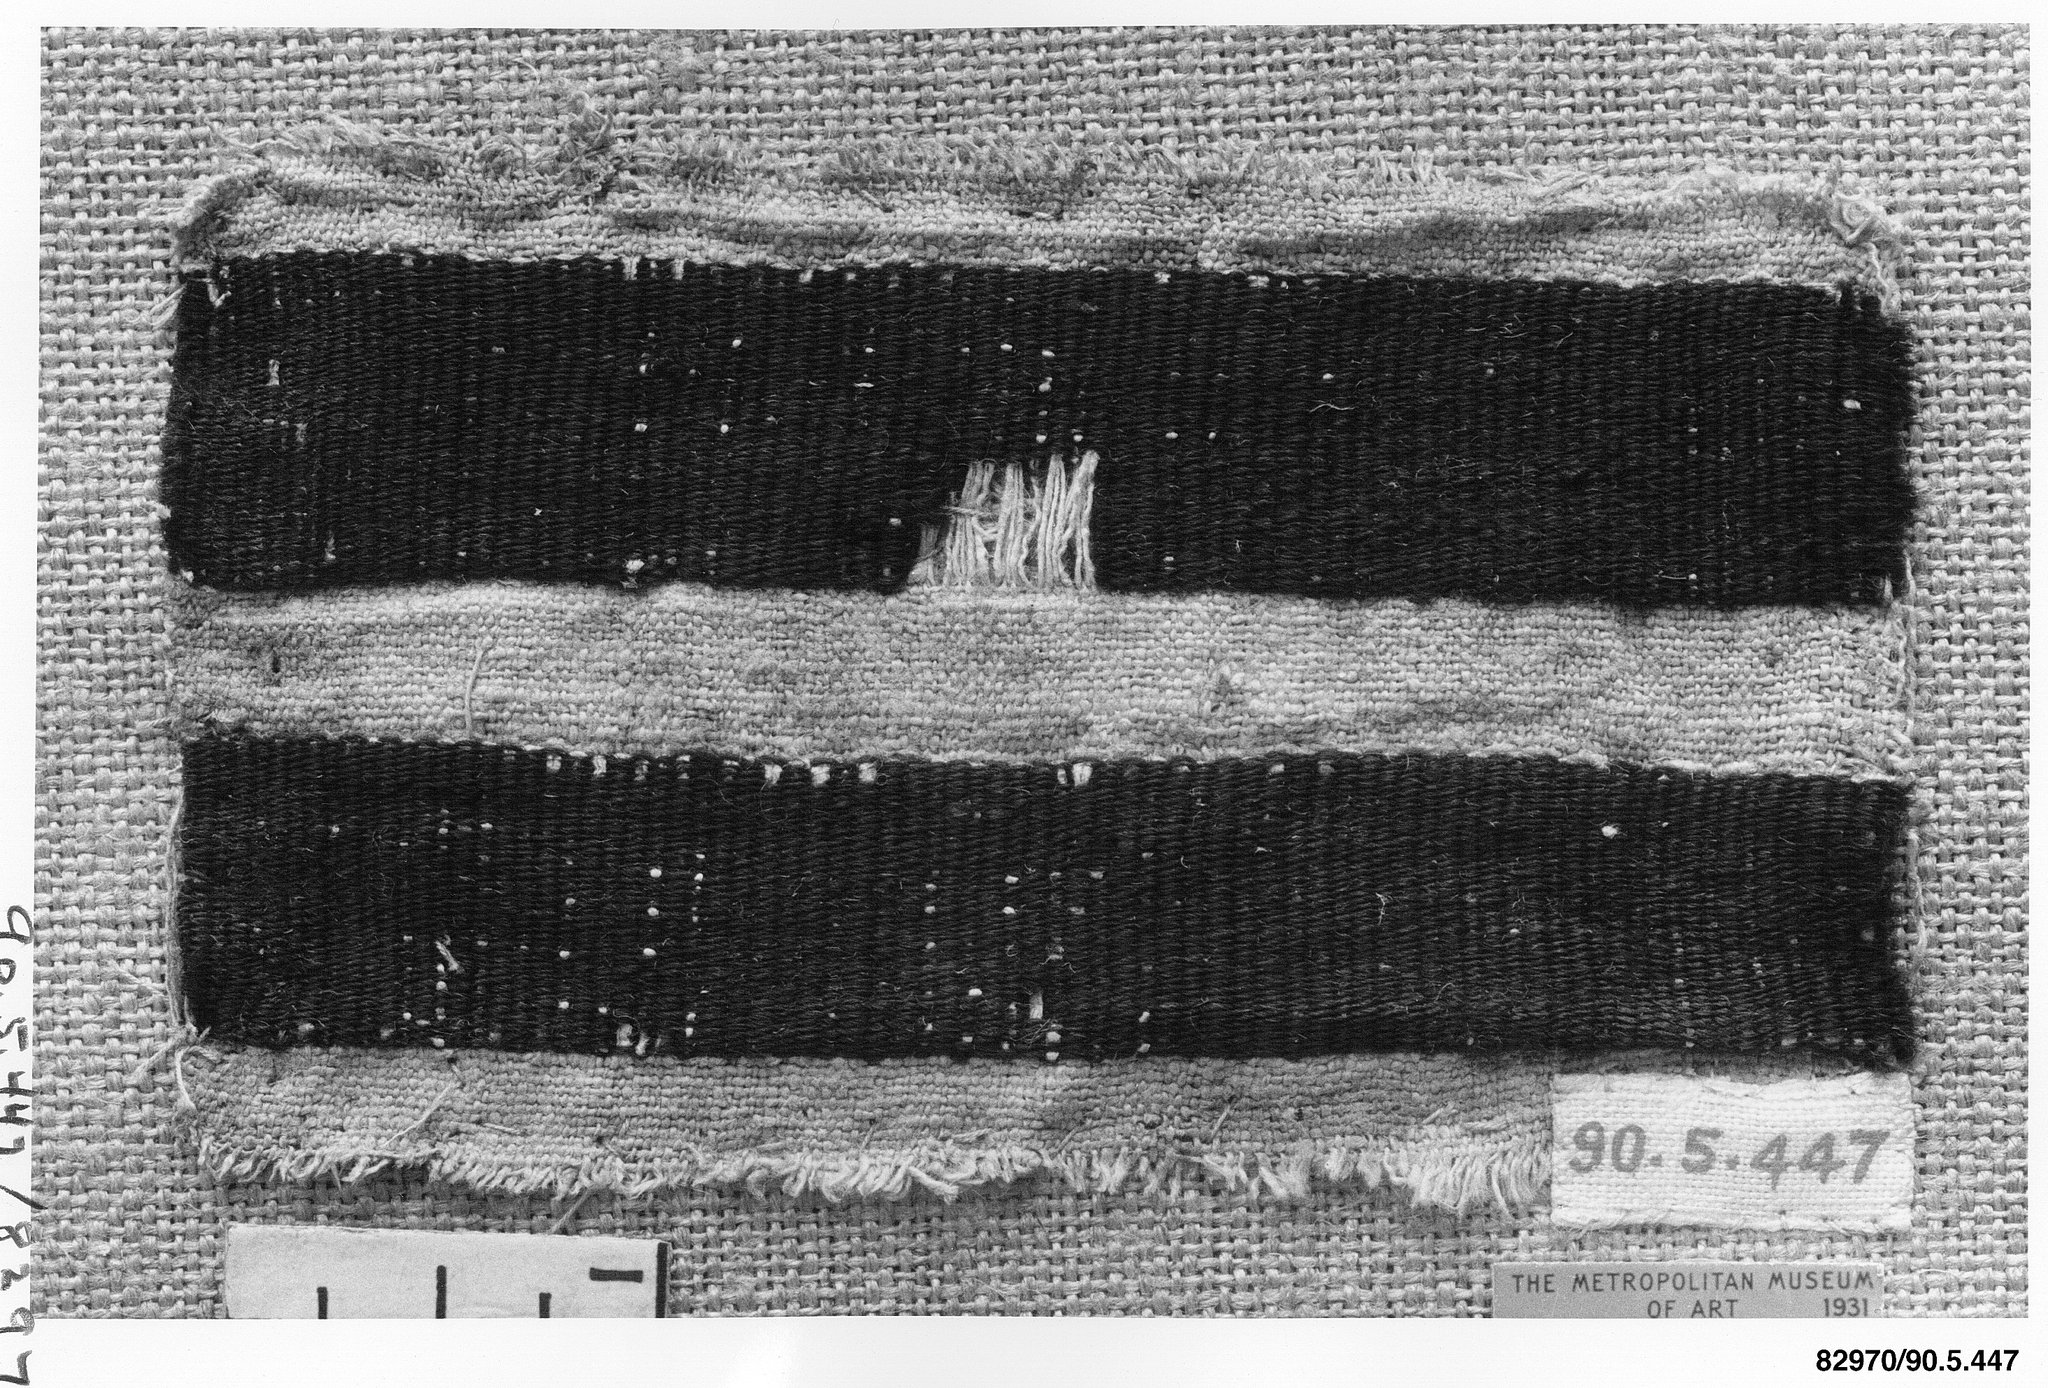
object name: textile fragment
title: Fragment of Sleeve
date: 101-300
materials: linen, wool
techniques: weave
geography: egypt